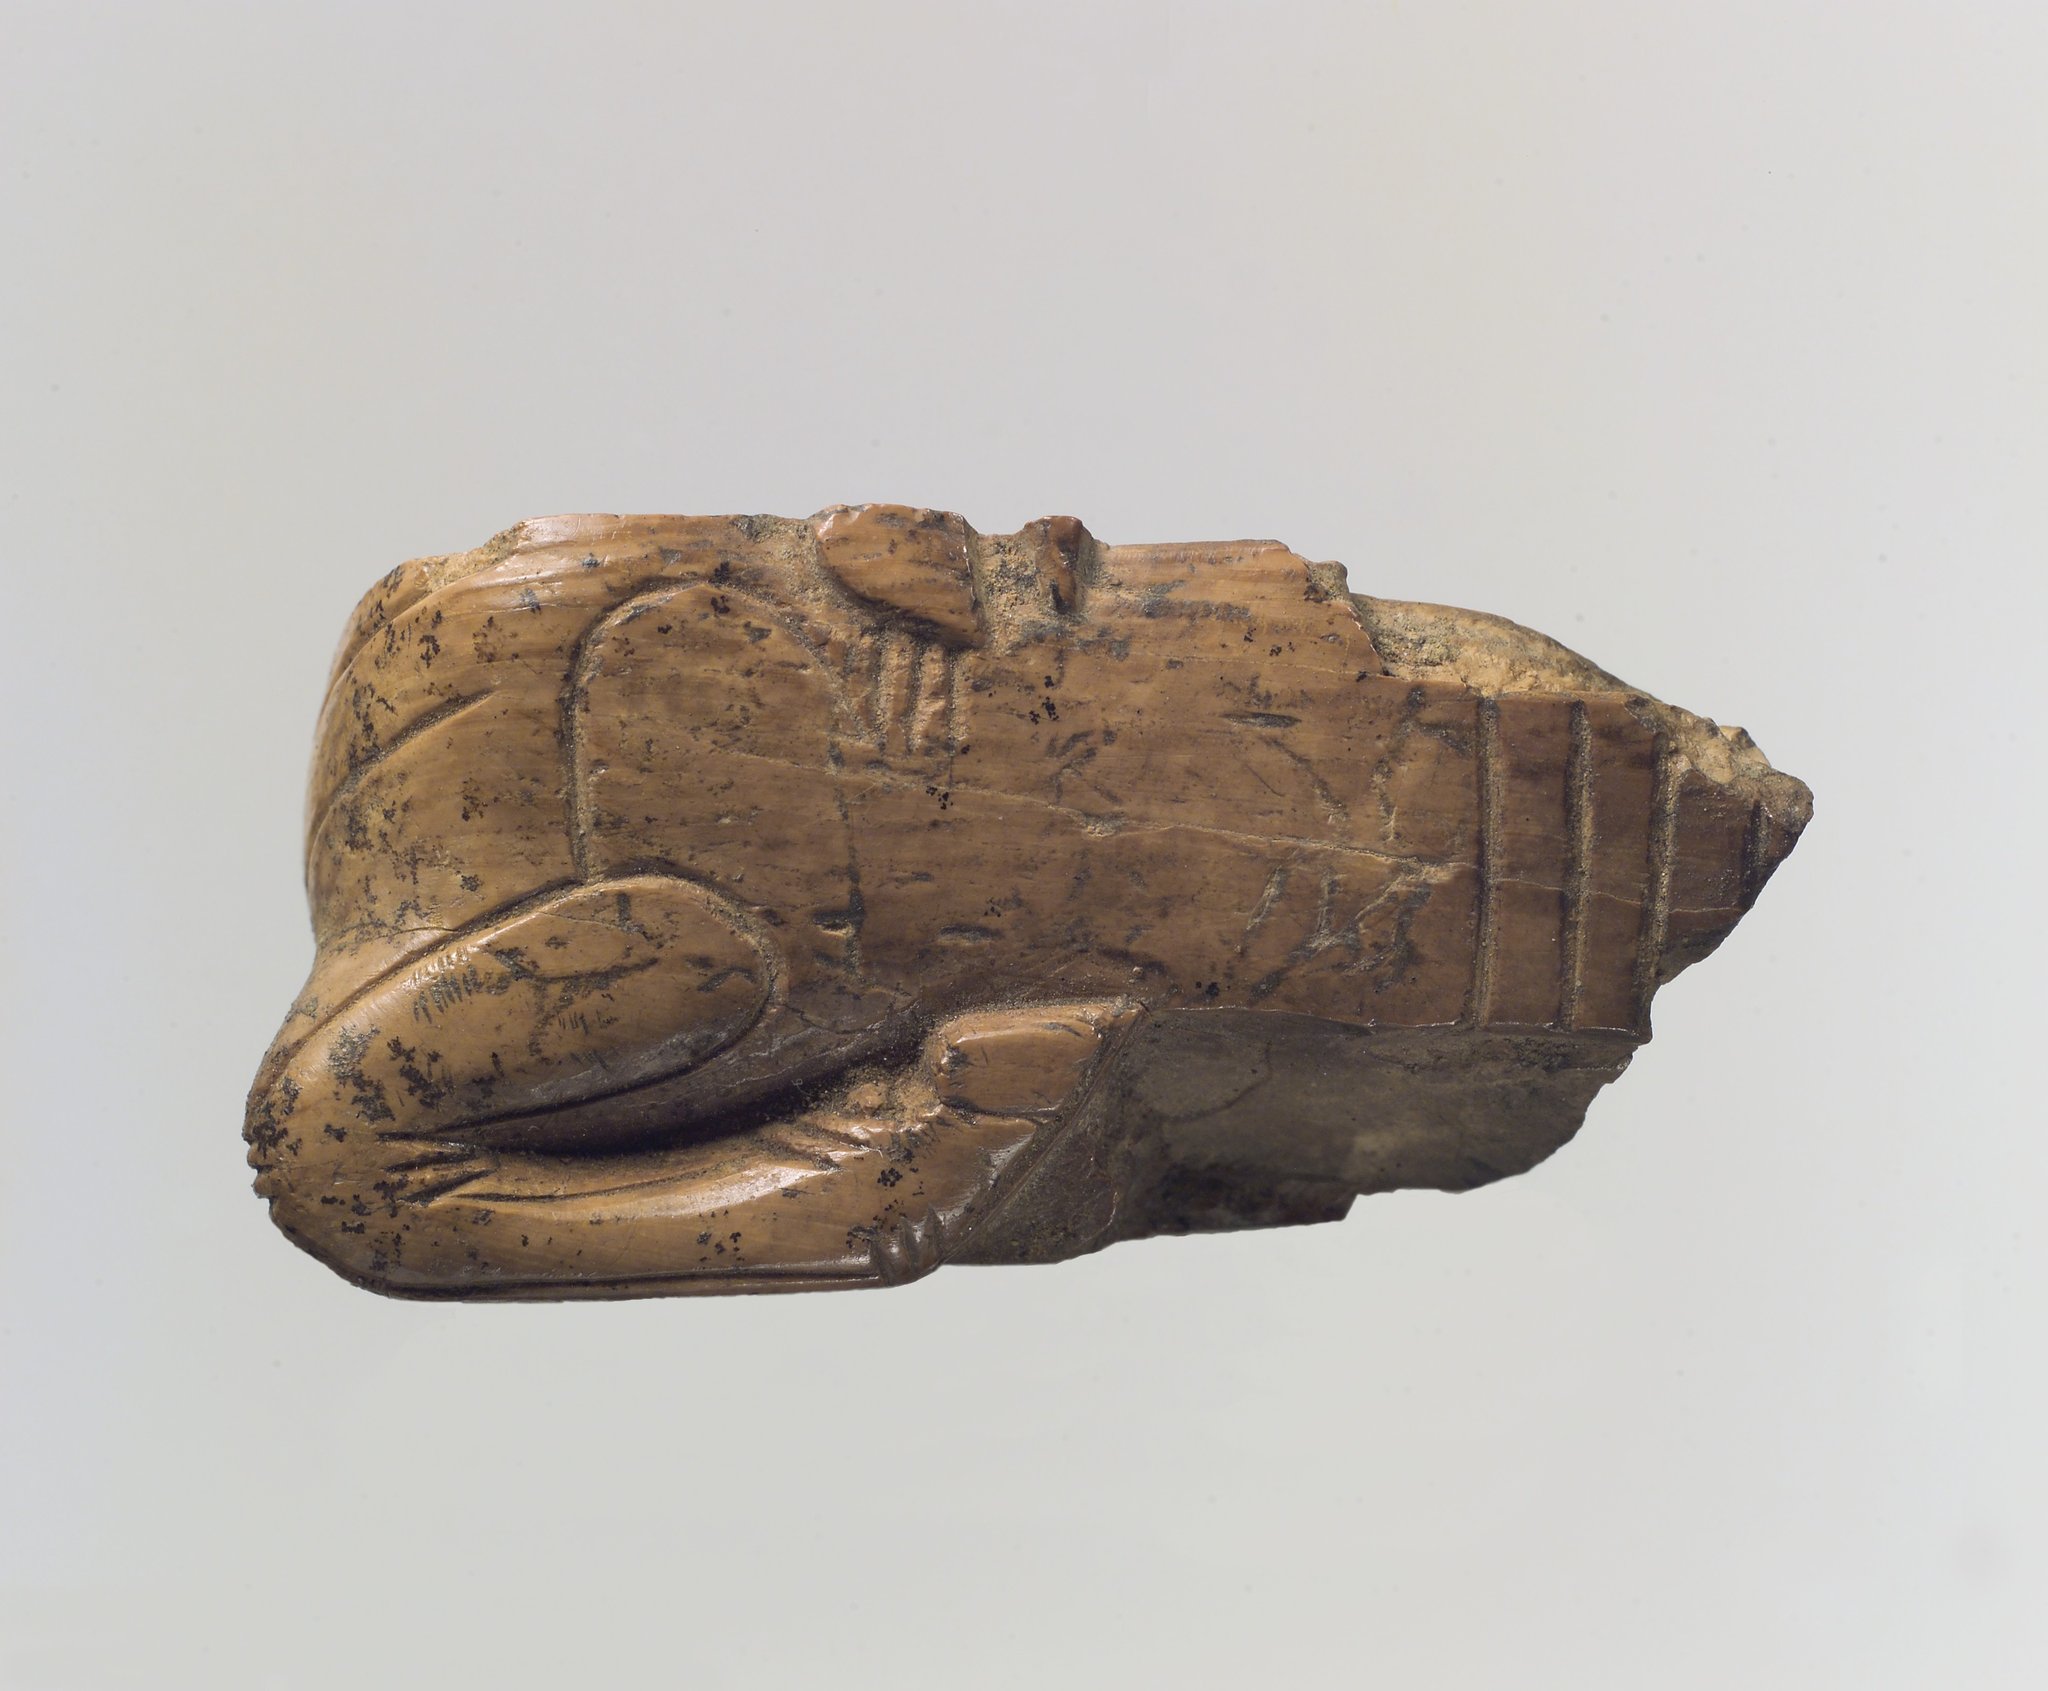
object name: pyxis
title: Pyxis fragment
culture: iranian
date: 900-801 BCE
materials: ivory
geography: iran